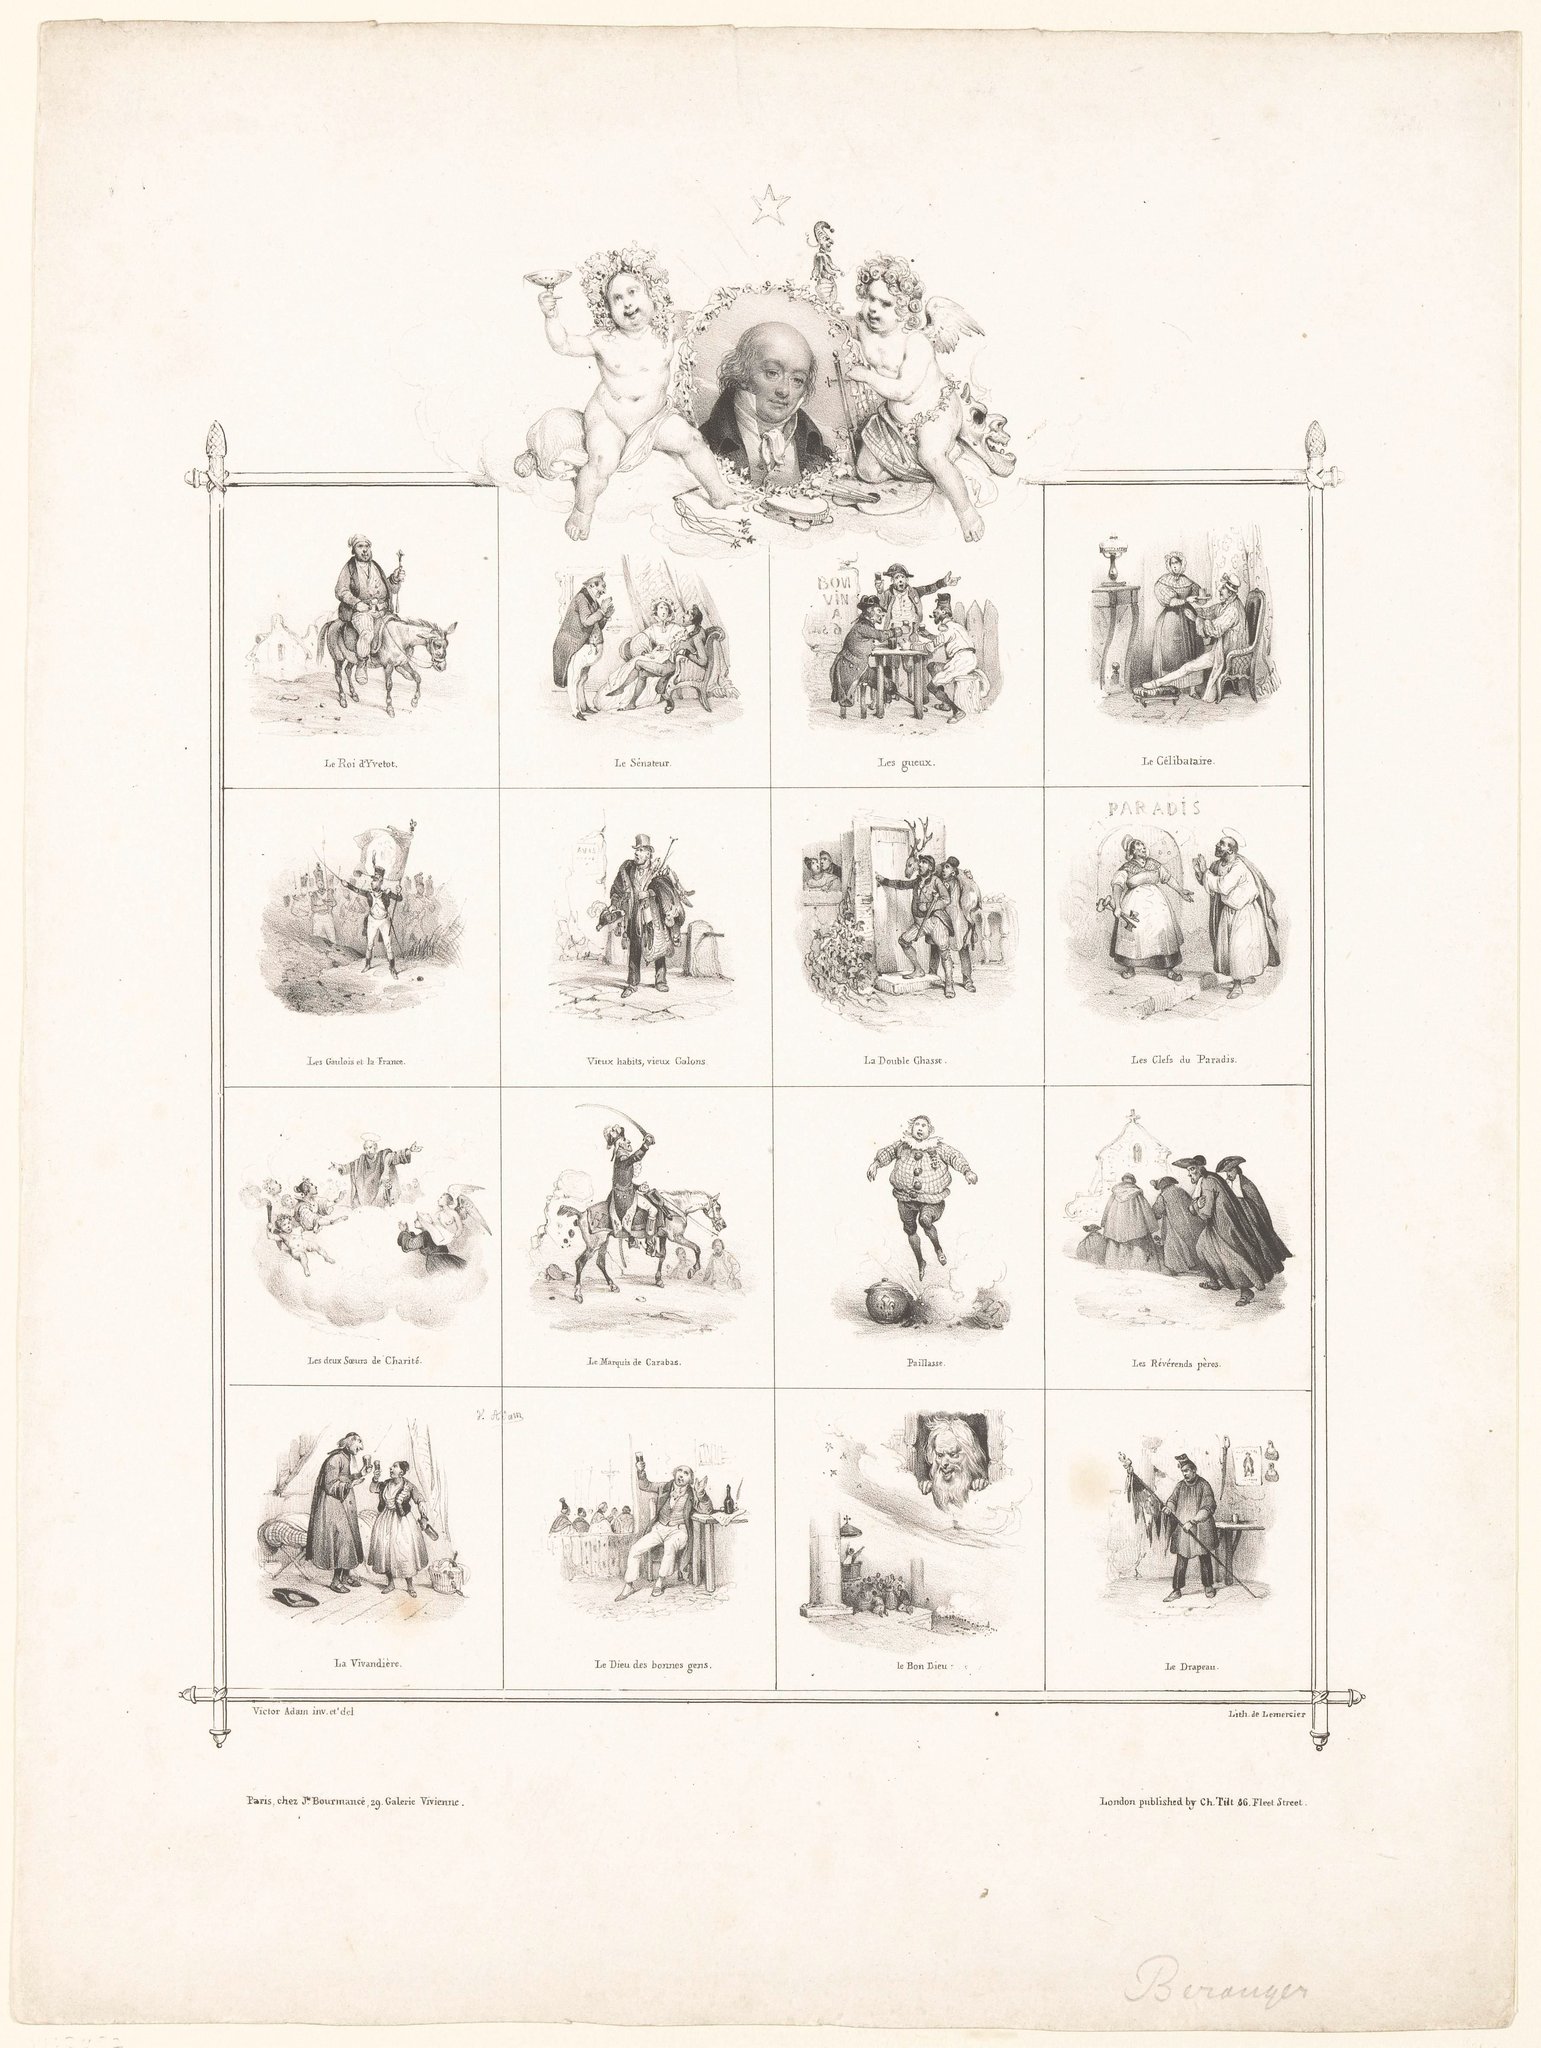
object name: print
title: Portret van Pierre-Jean de Béranger en zestien voorstellingen uit zijn gedichten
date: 1834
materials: paper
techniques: lithograph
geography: paris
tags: paris, pierre-jean de béranger, historical persons, portrait of a writer, (scenes from) specific works of literature (with author, title)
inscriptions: collector's mark: Lugt 2228, annotation: ‘Beranger’